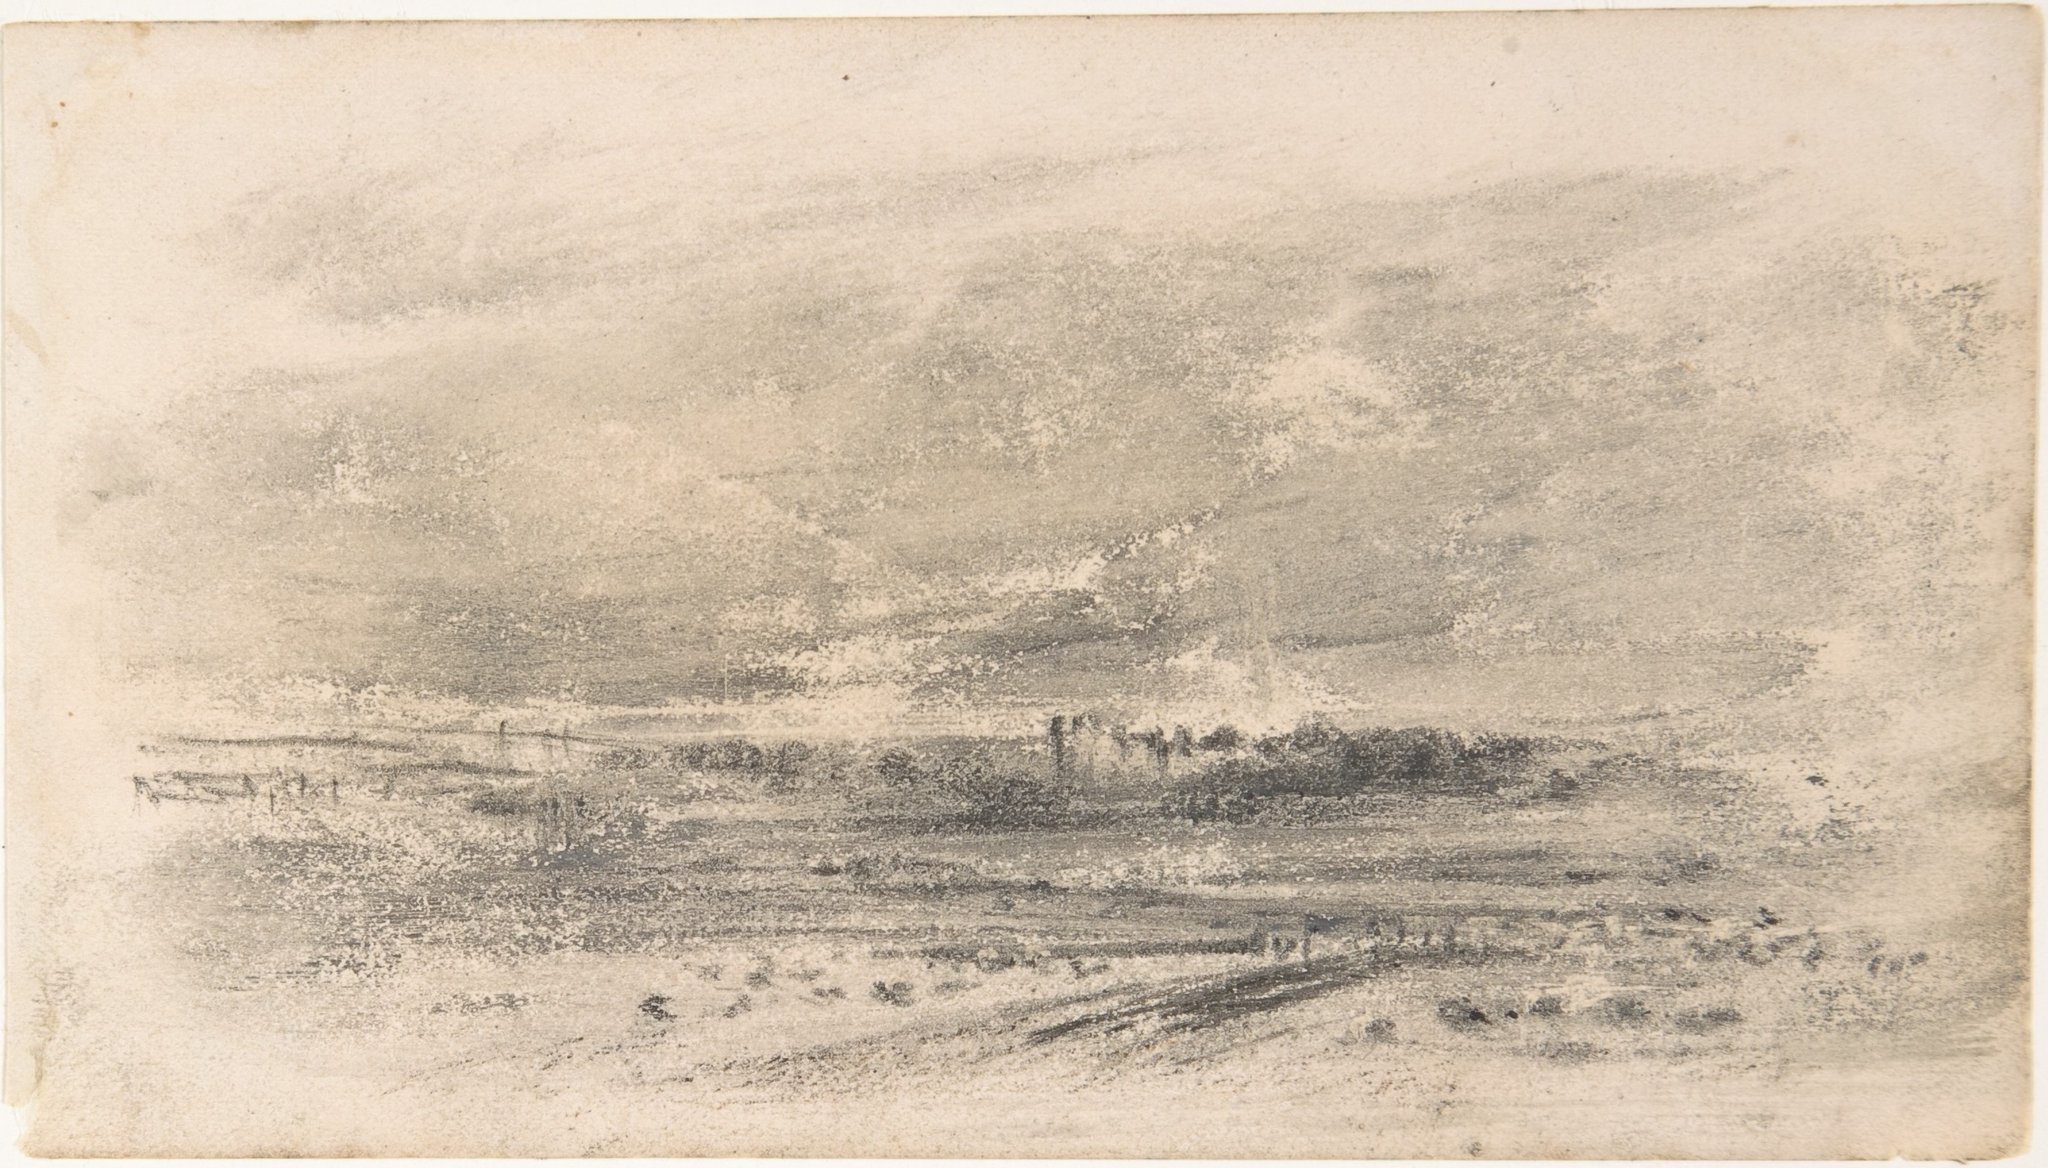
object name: drawing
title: The South Downs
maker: anonymous, british, early 19th century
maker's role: artist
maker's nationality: british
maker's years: 1800-1850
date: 1801-1900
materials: ink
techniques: brush, pen, wash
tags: hills